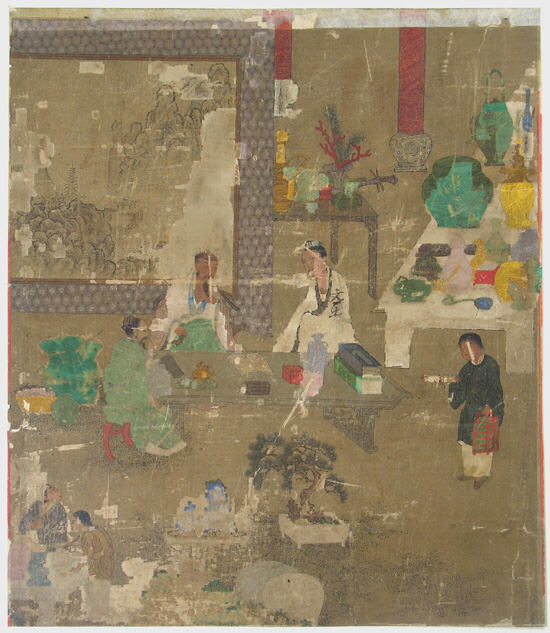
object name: album leaf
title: Examining Antiques at Literati Gathering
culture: korean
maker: wang li mu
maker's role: artist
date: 1701-1800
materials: ink, silk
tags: men,tables